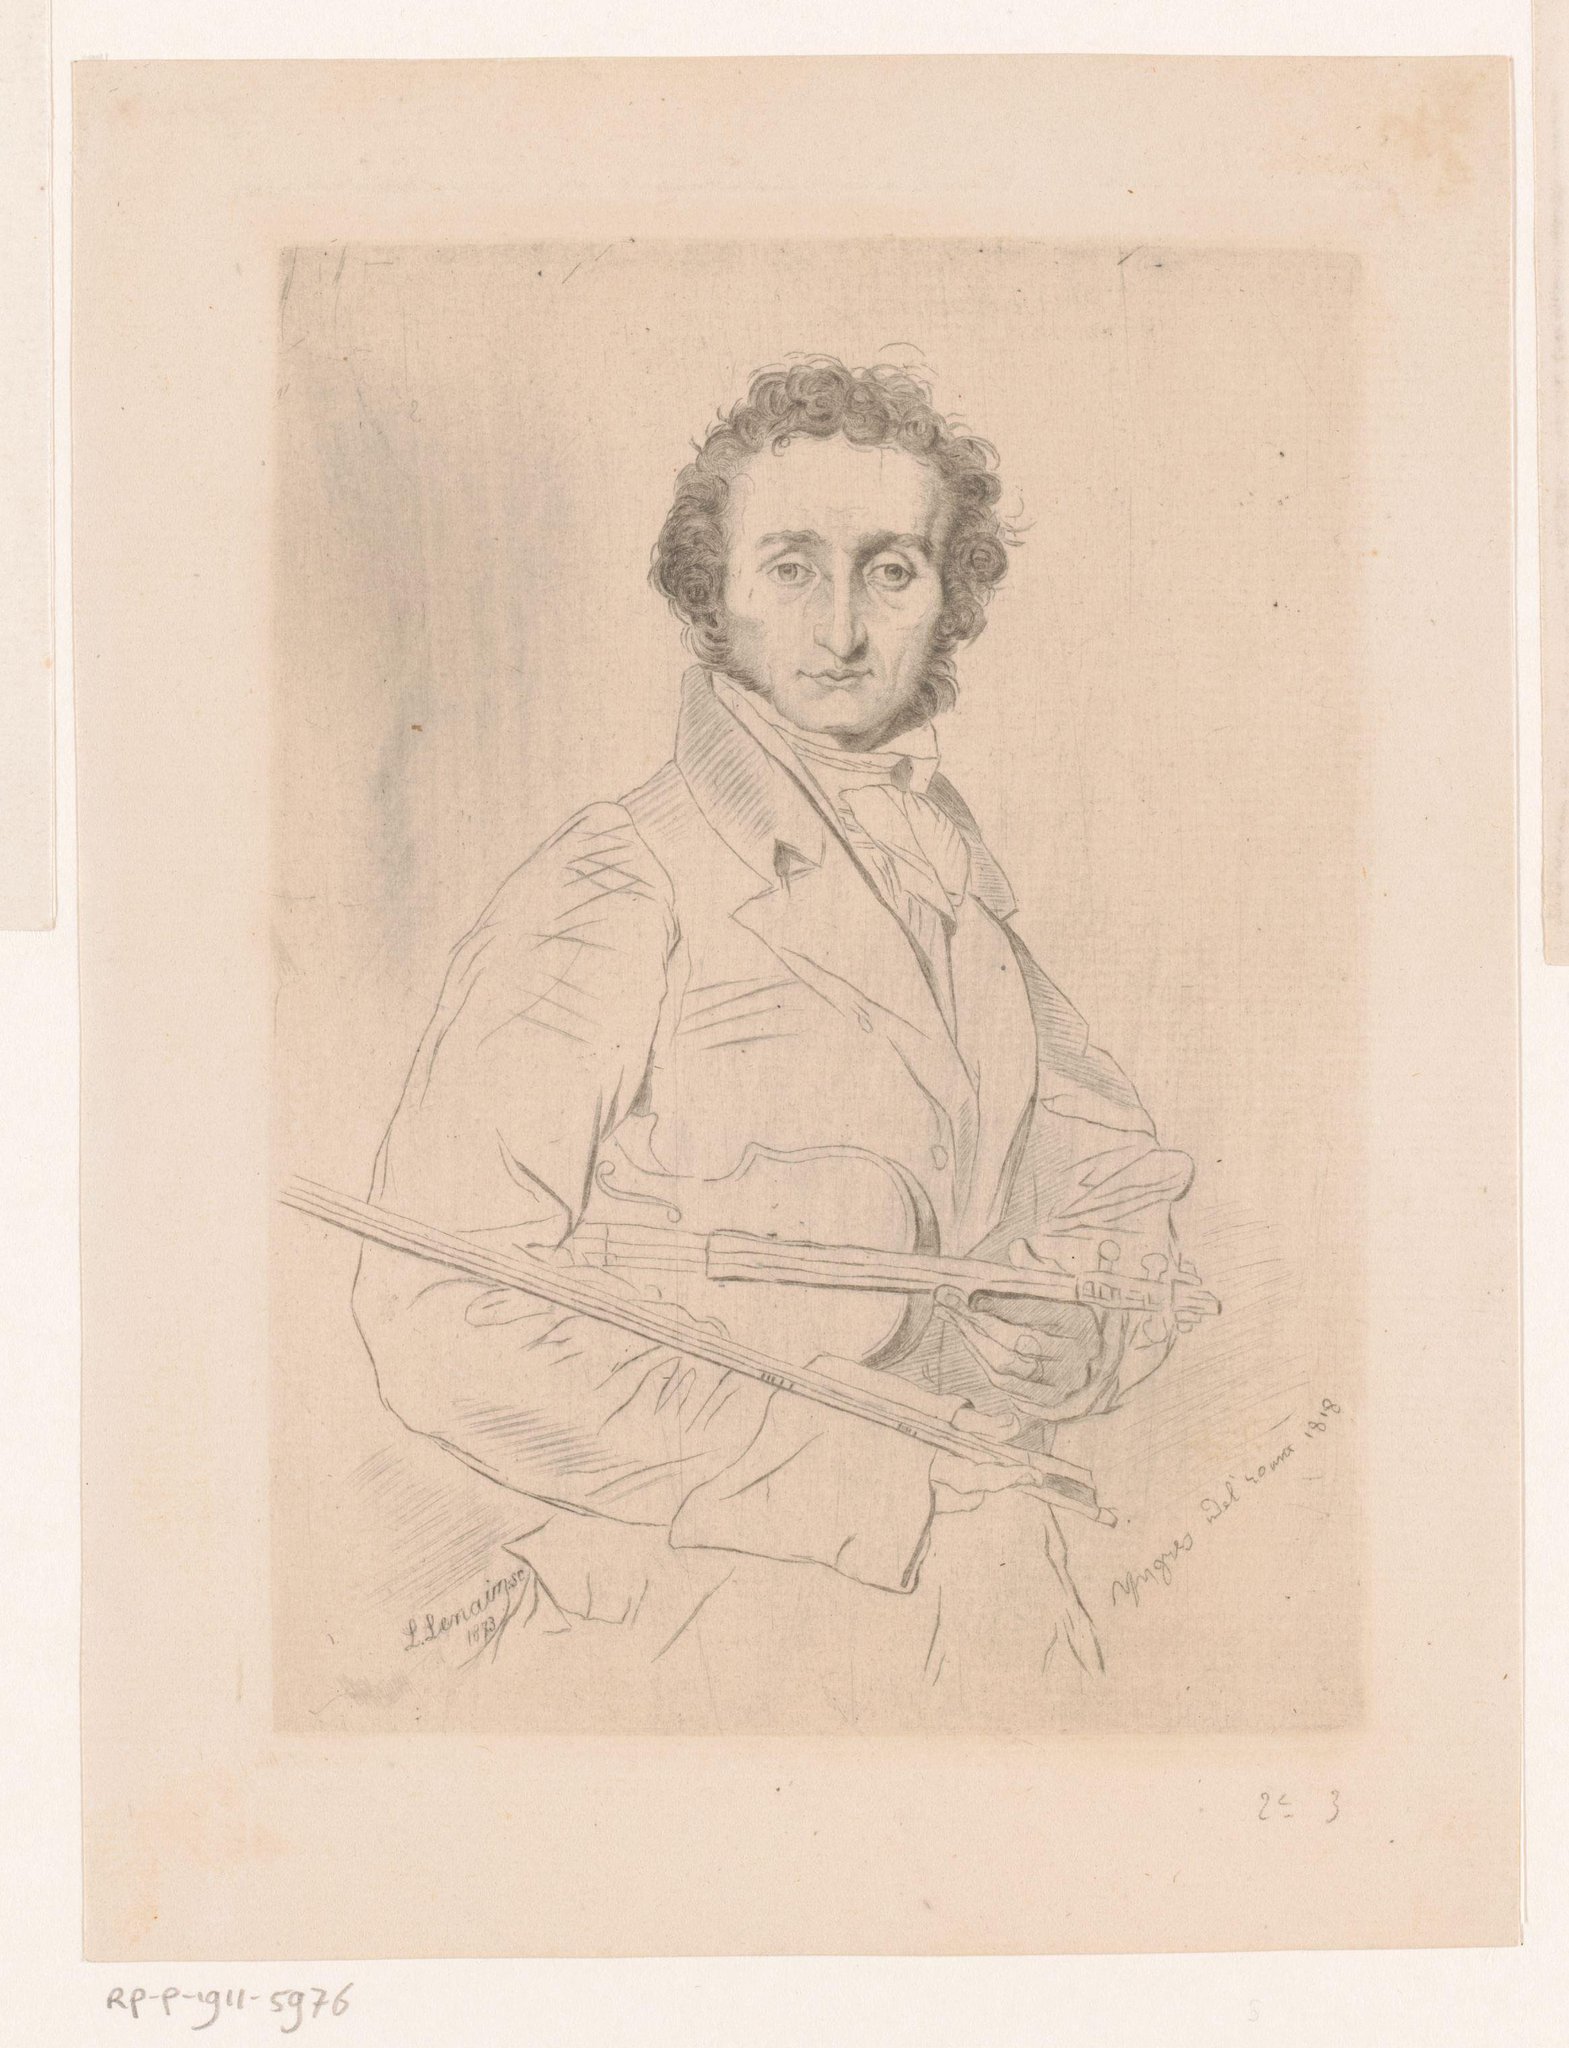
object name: print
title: Portret van Niccolò Paganini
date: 1873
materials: paper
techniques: etching, intaglio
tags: musician, historical persons, violin, fiddle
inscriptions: collector's mark: Lugt 2228, inscription: ‘LLeNain 1e 2’